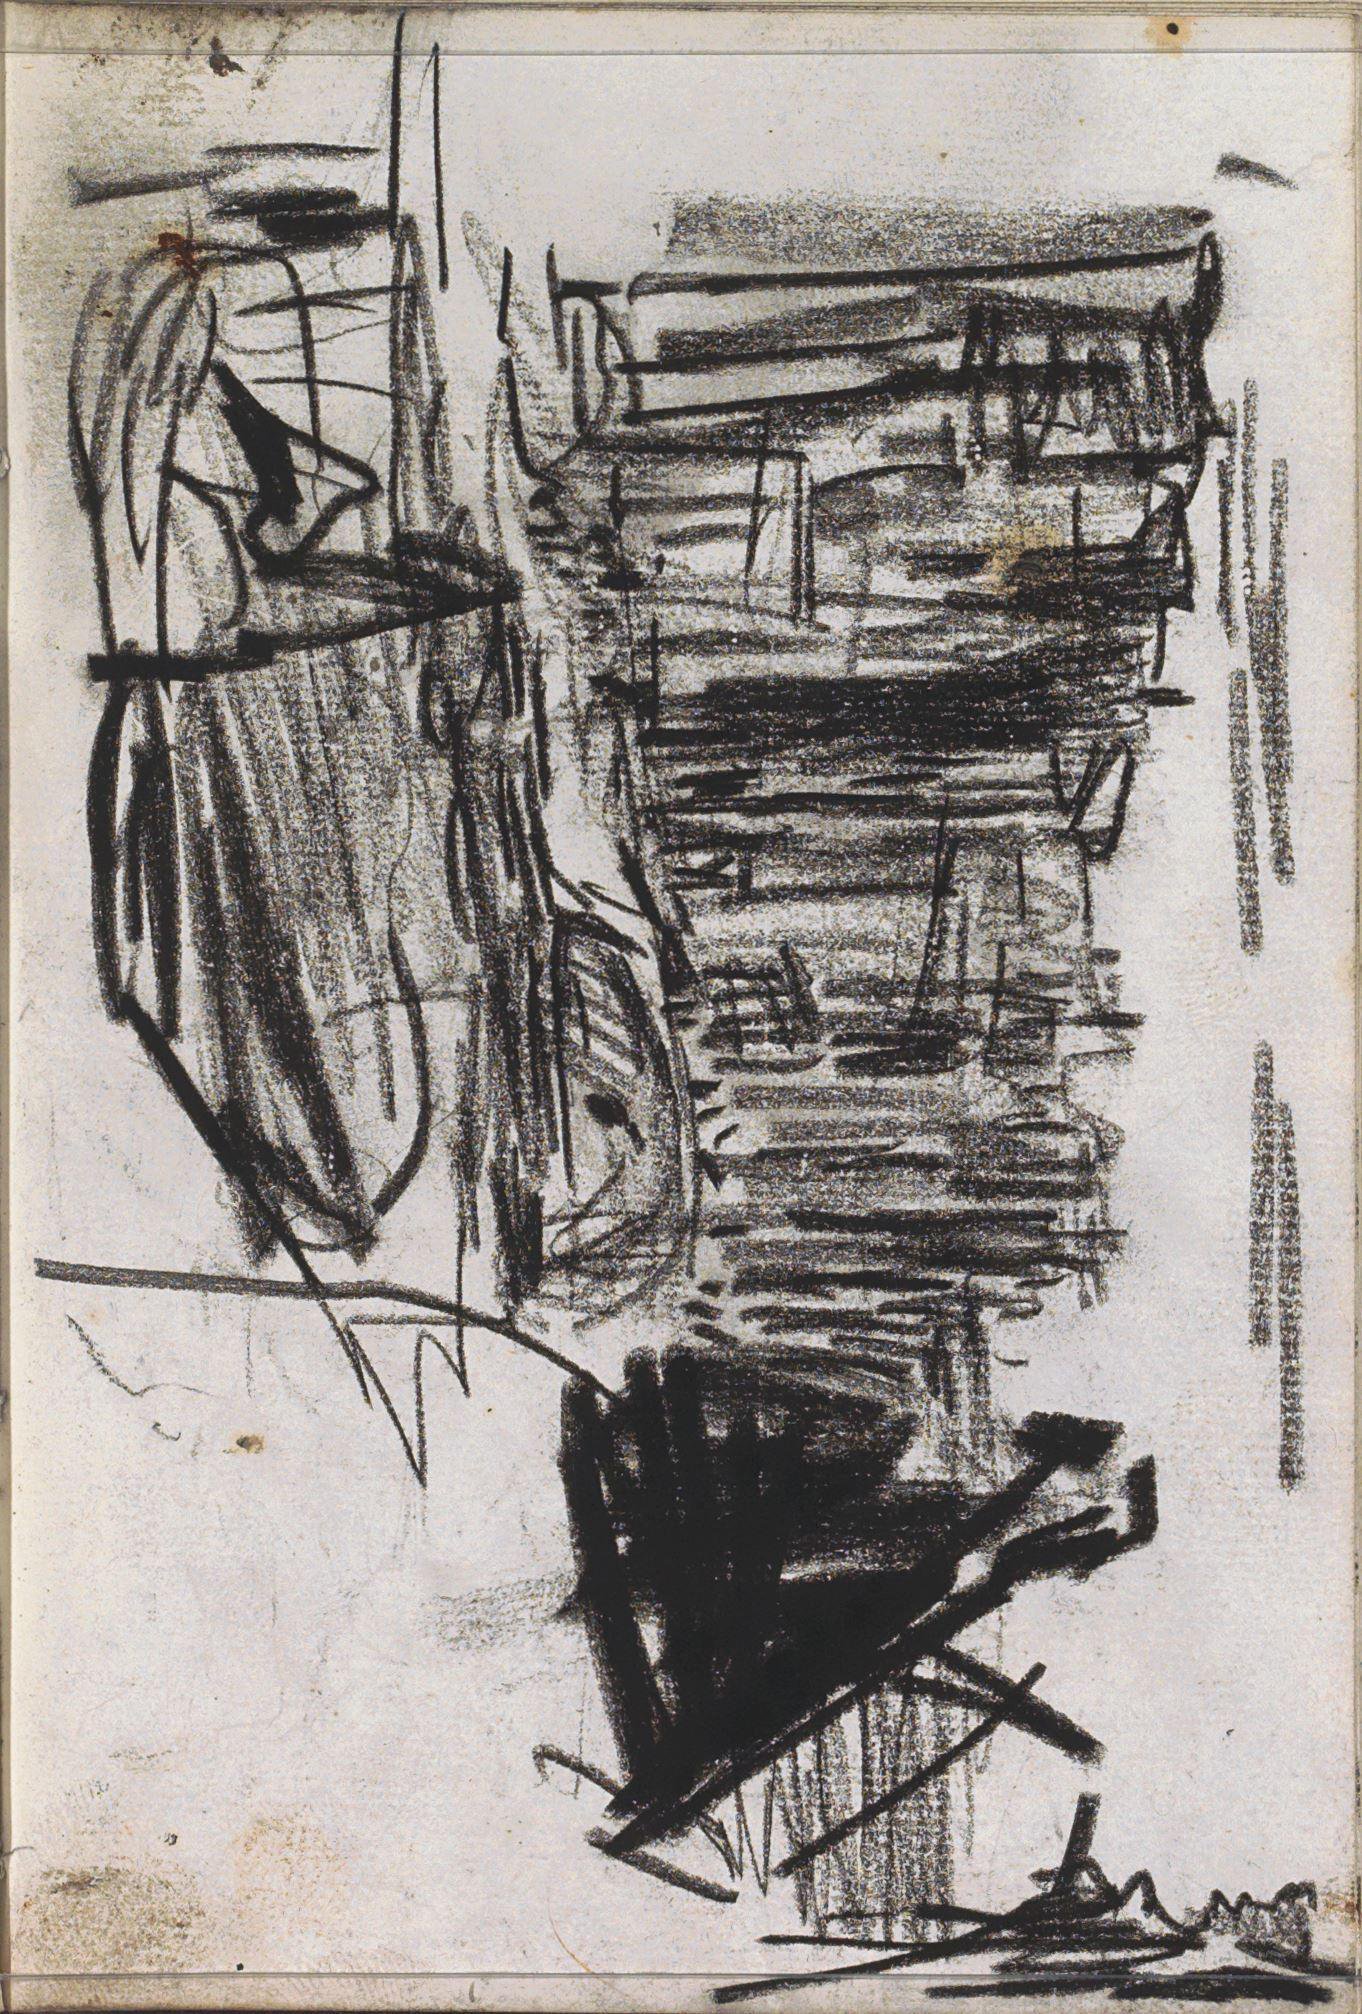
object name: sketchbook leaf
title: Stadsgezicht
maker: isaac israels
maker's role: draughtsman, painter, print maker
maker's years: 1865-1934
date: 1875-1934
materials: chalk, paper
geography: the hague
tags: city-view, and landscape with man-made constructions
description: Pagina 18 uit schetsboek XLIV met 43 pagina's.